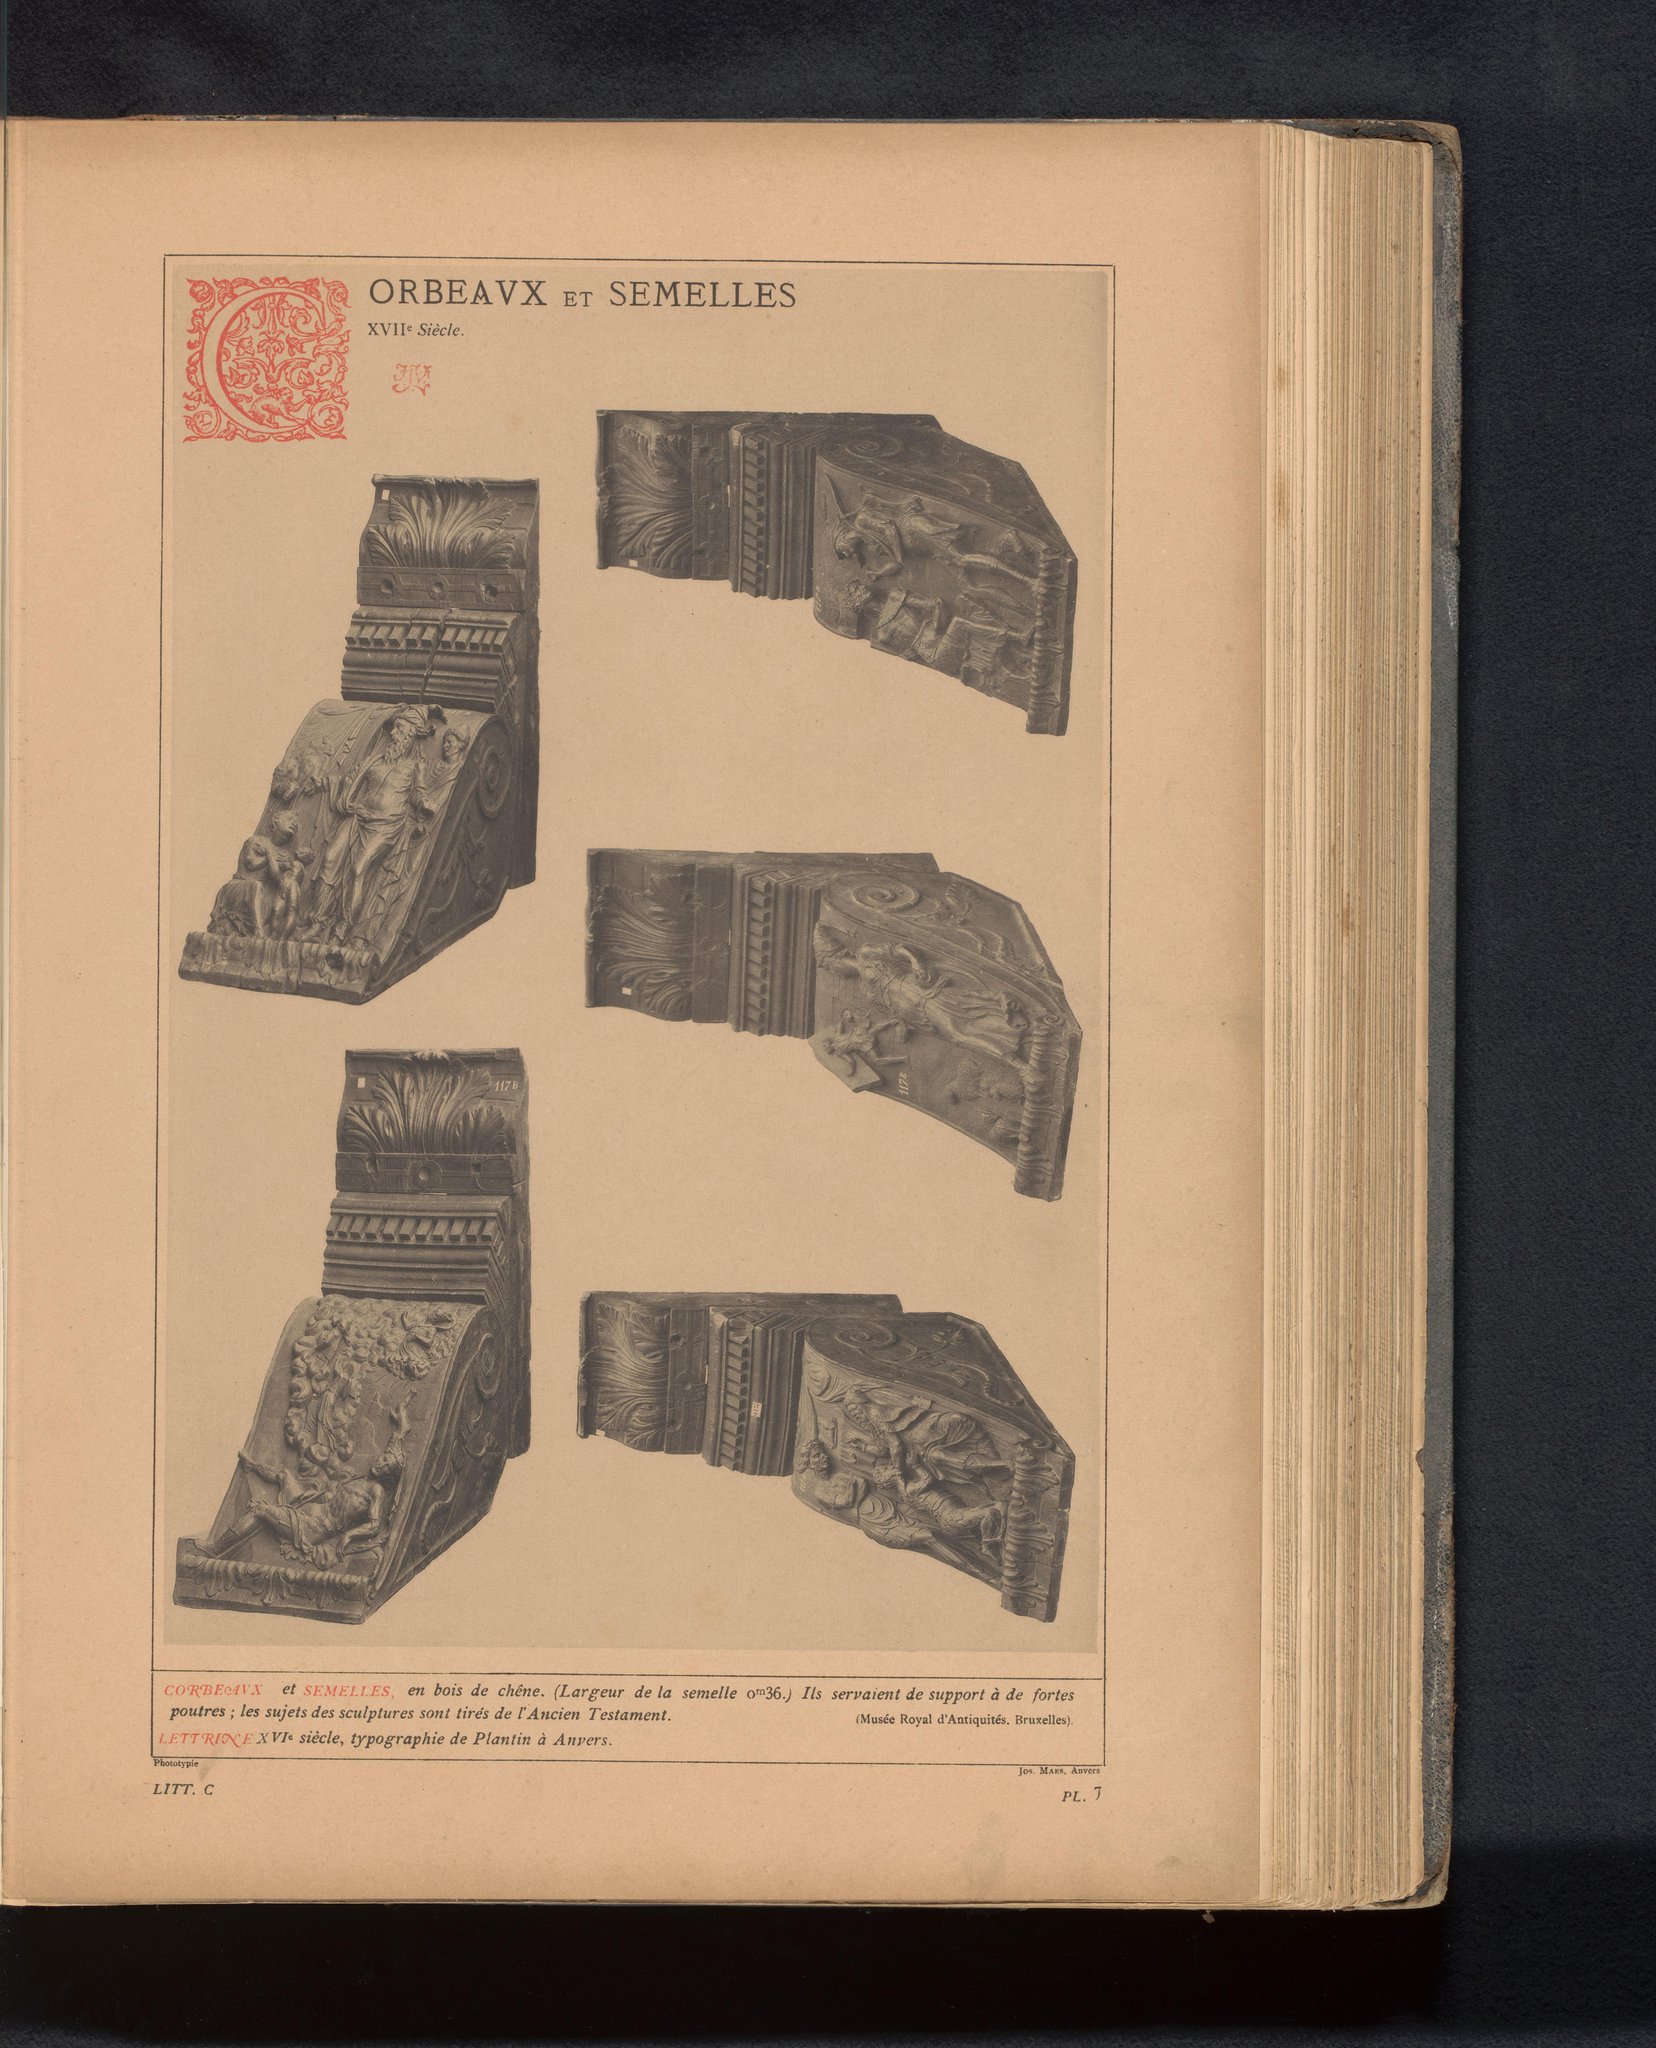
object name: photomechanical print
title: Corbeaux et semelles, XIIIe Siècle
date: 1875-1880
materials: paper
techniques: photograph, photolithography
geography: antwerp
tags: old testament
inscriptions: monogram: ‘JJvY’, inscription: ‘Corbeaux et semelles (...)’, inscription: ‘LITT. C. - PL. 7’